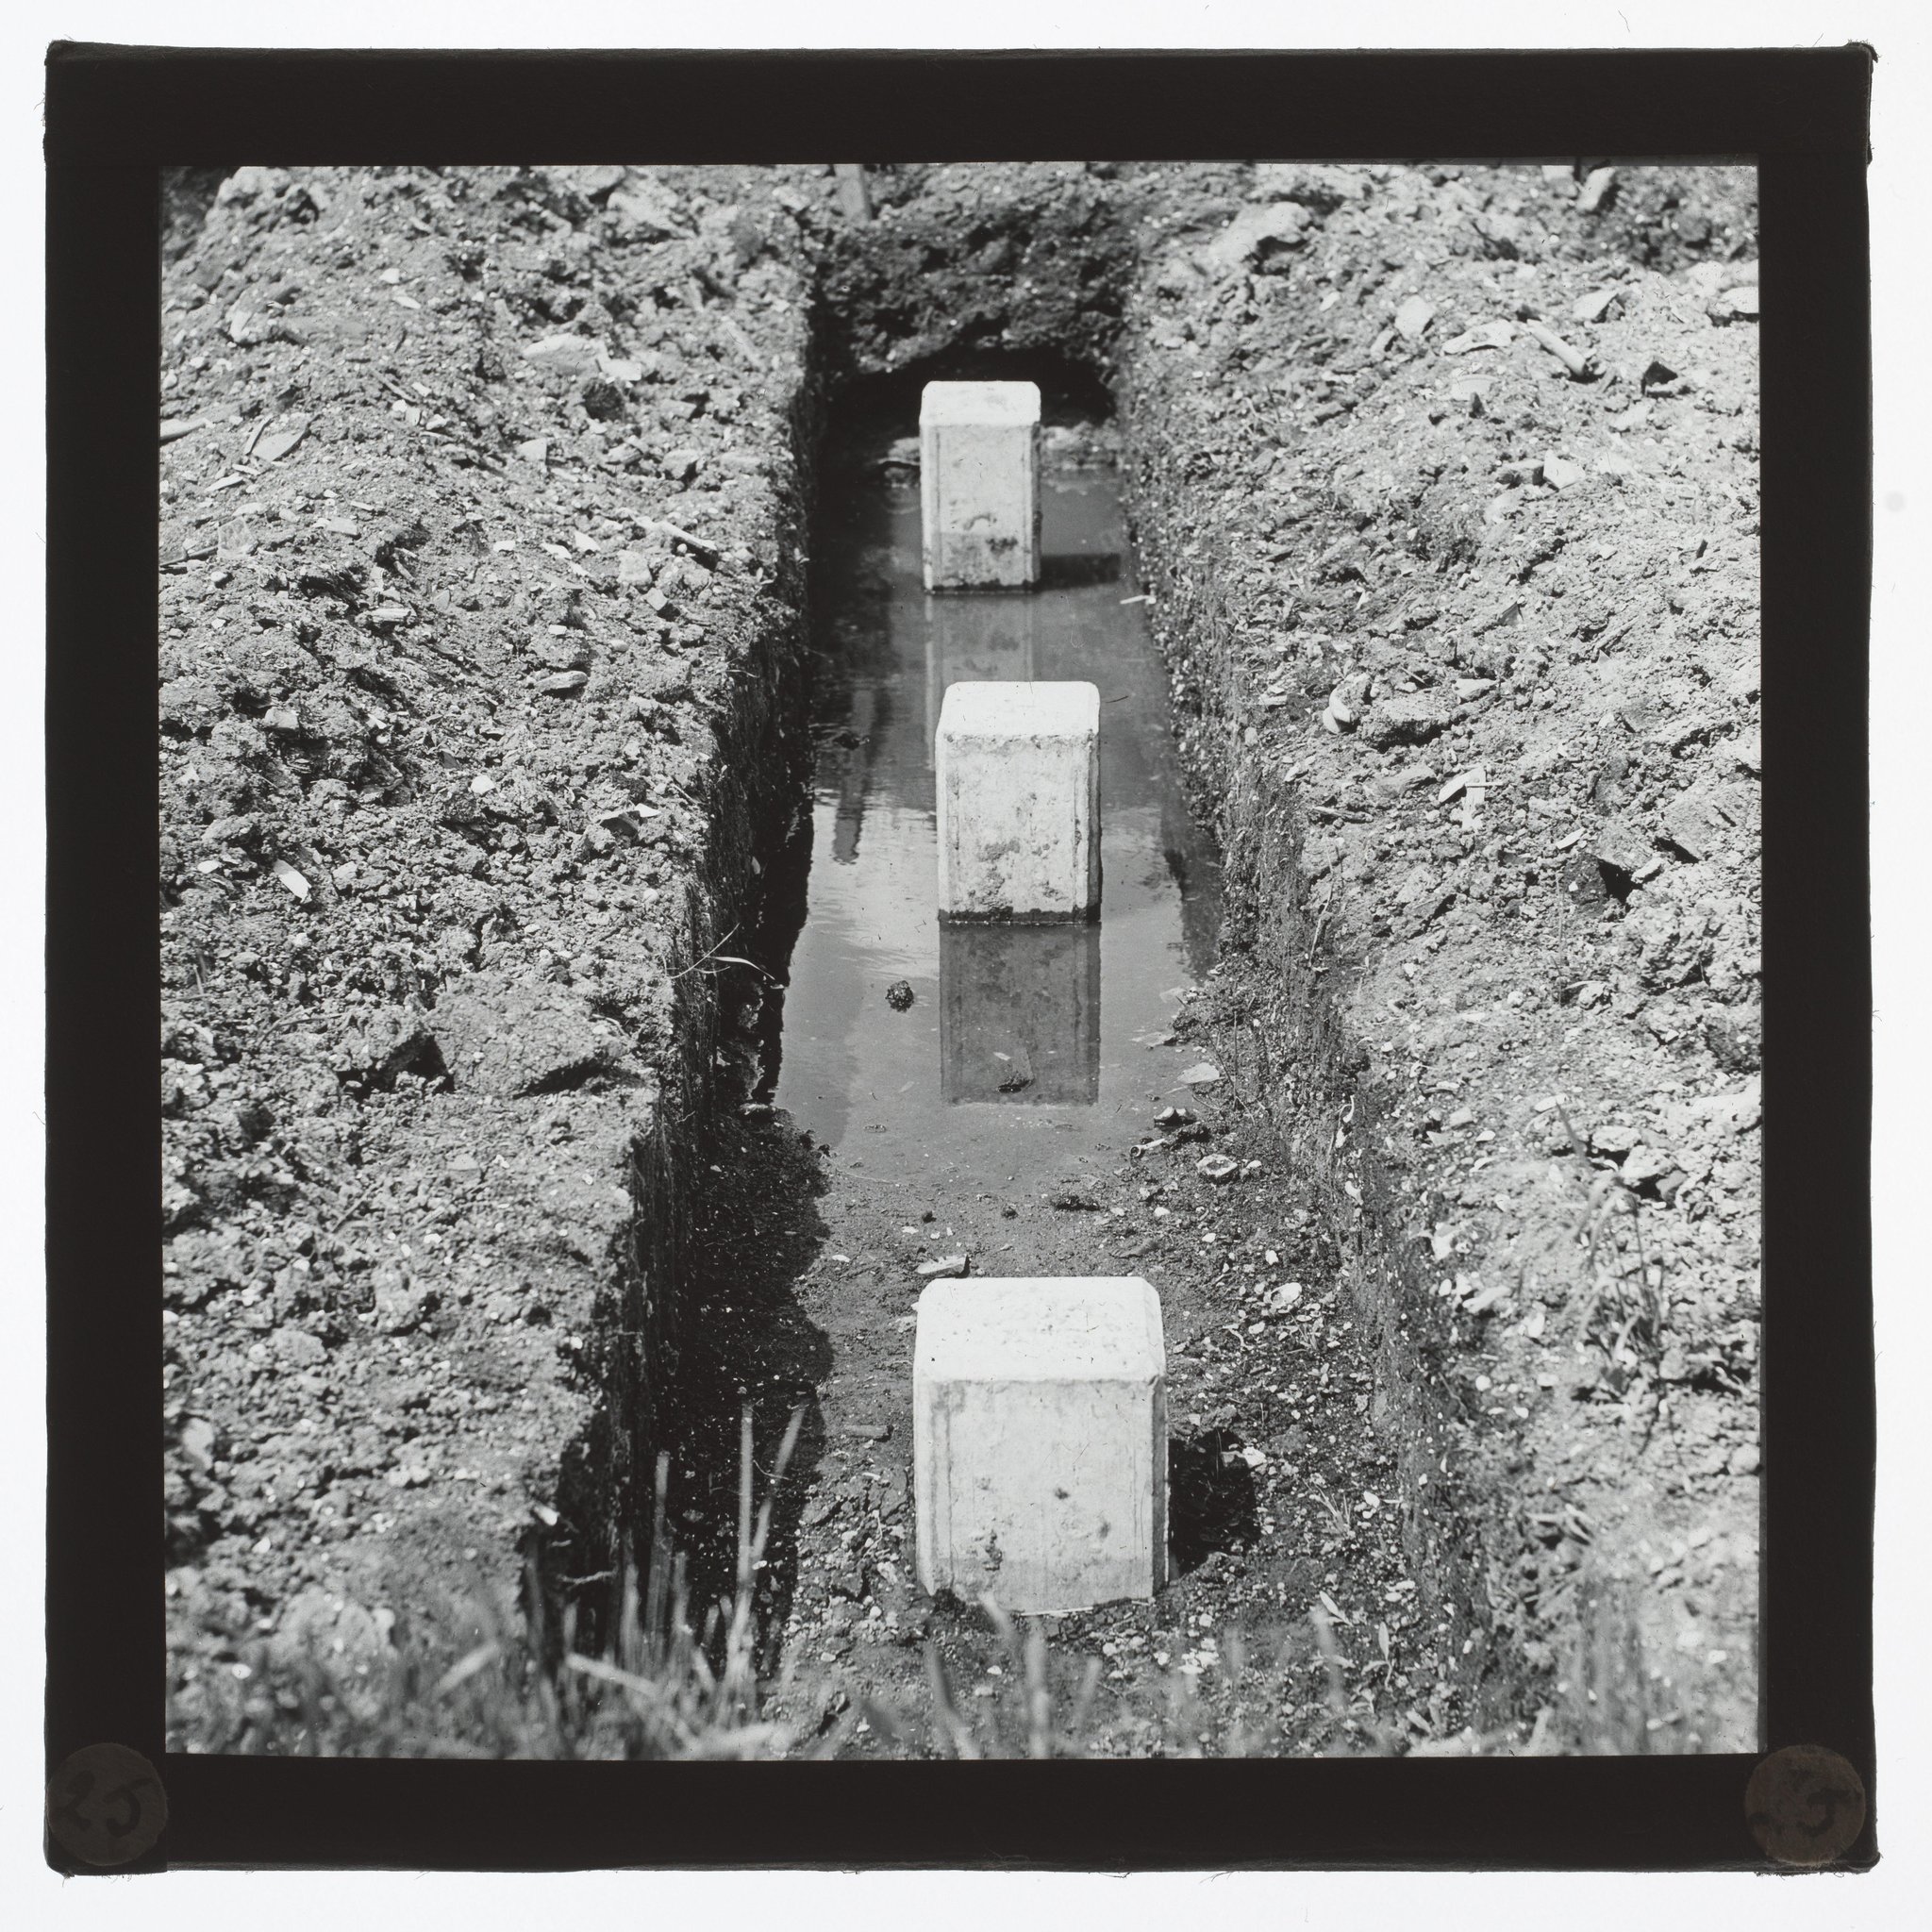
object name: lantern slide photographic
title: Palen in de grond, Zuid-Holland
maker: Anonymous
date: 1956-1960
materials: glass, paper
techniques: gelatin silver transparency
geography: south holland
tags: building-site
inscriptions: number: ‘25’